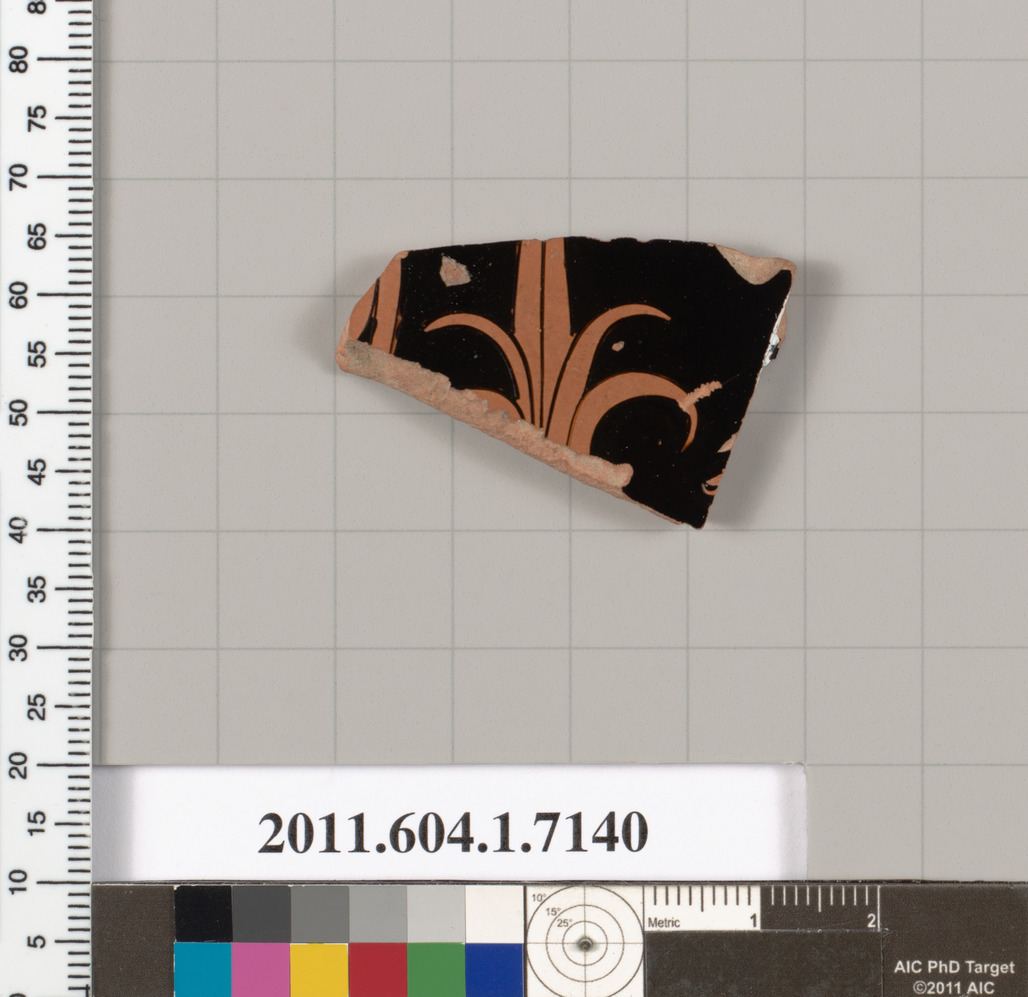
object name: kylix fragment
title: Terracotta fragment of a kylix (drinking cup)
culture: greek, attic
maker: makron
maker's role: artist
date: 500-480 BCE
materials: terracotta